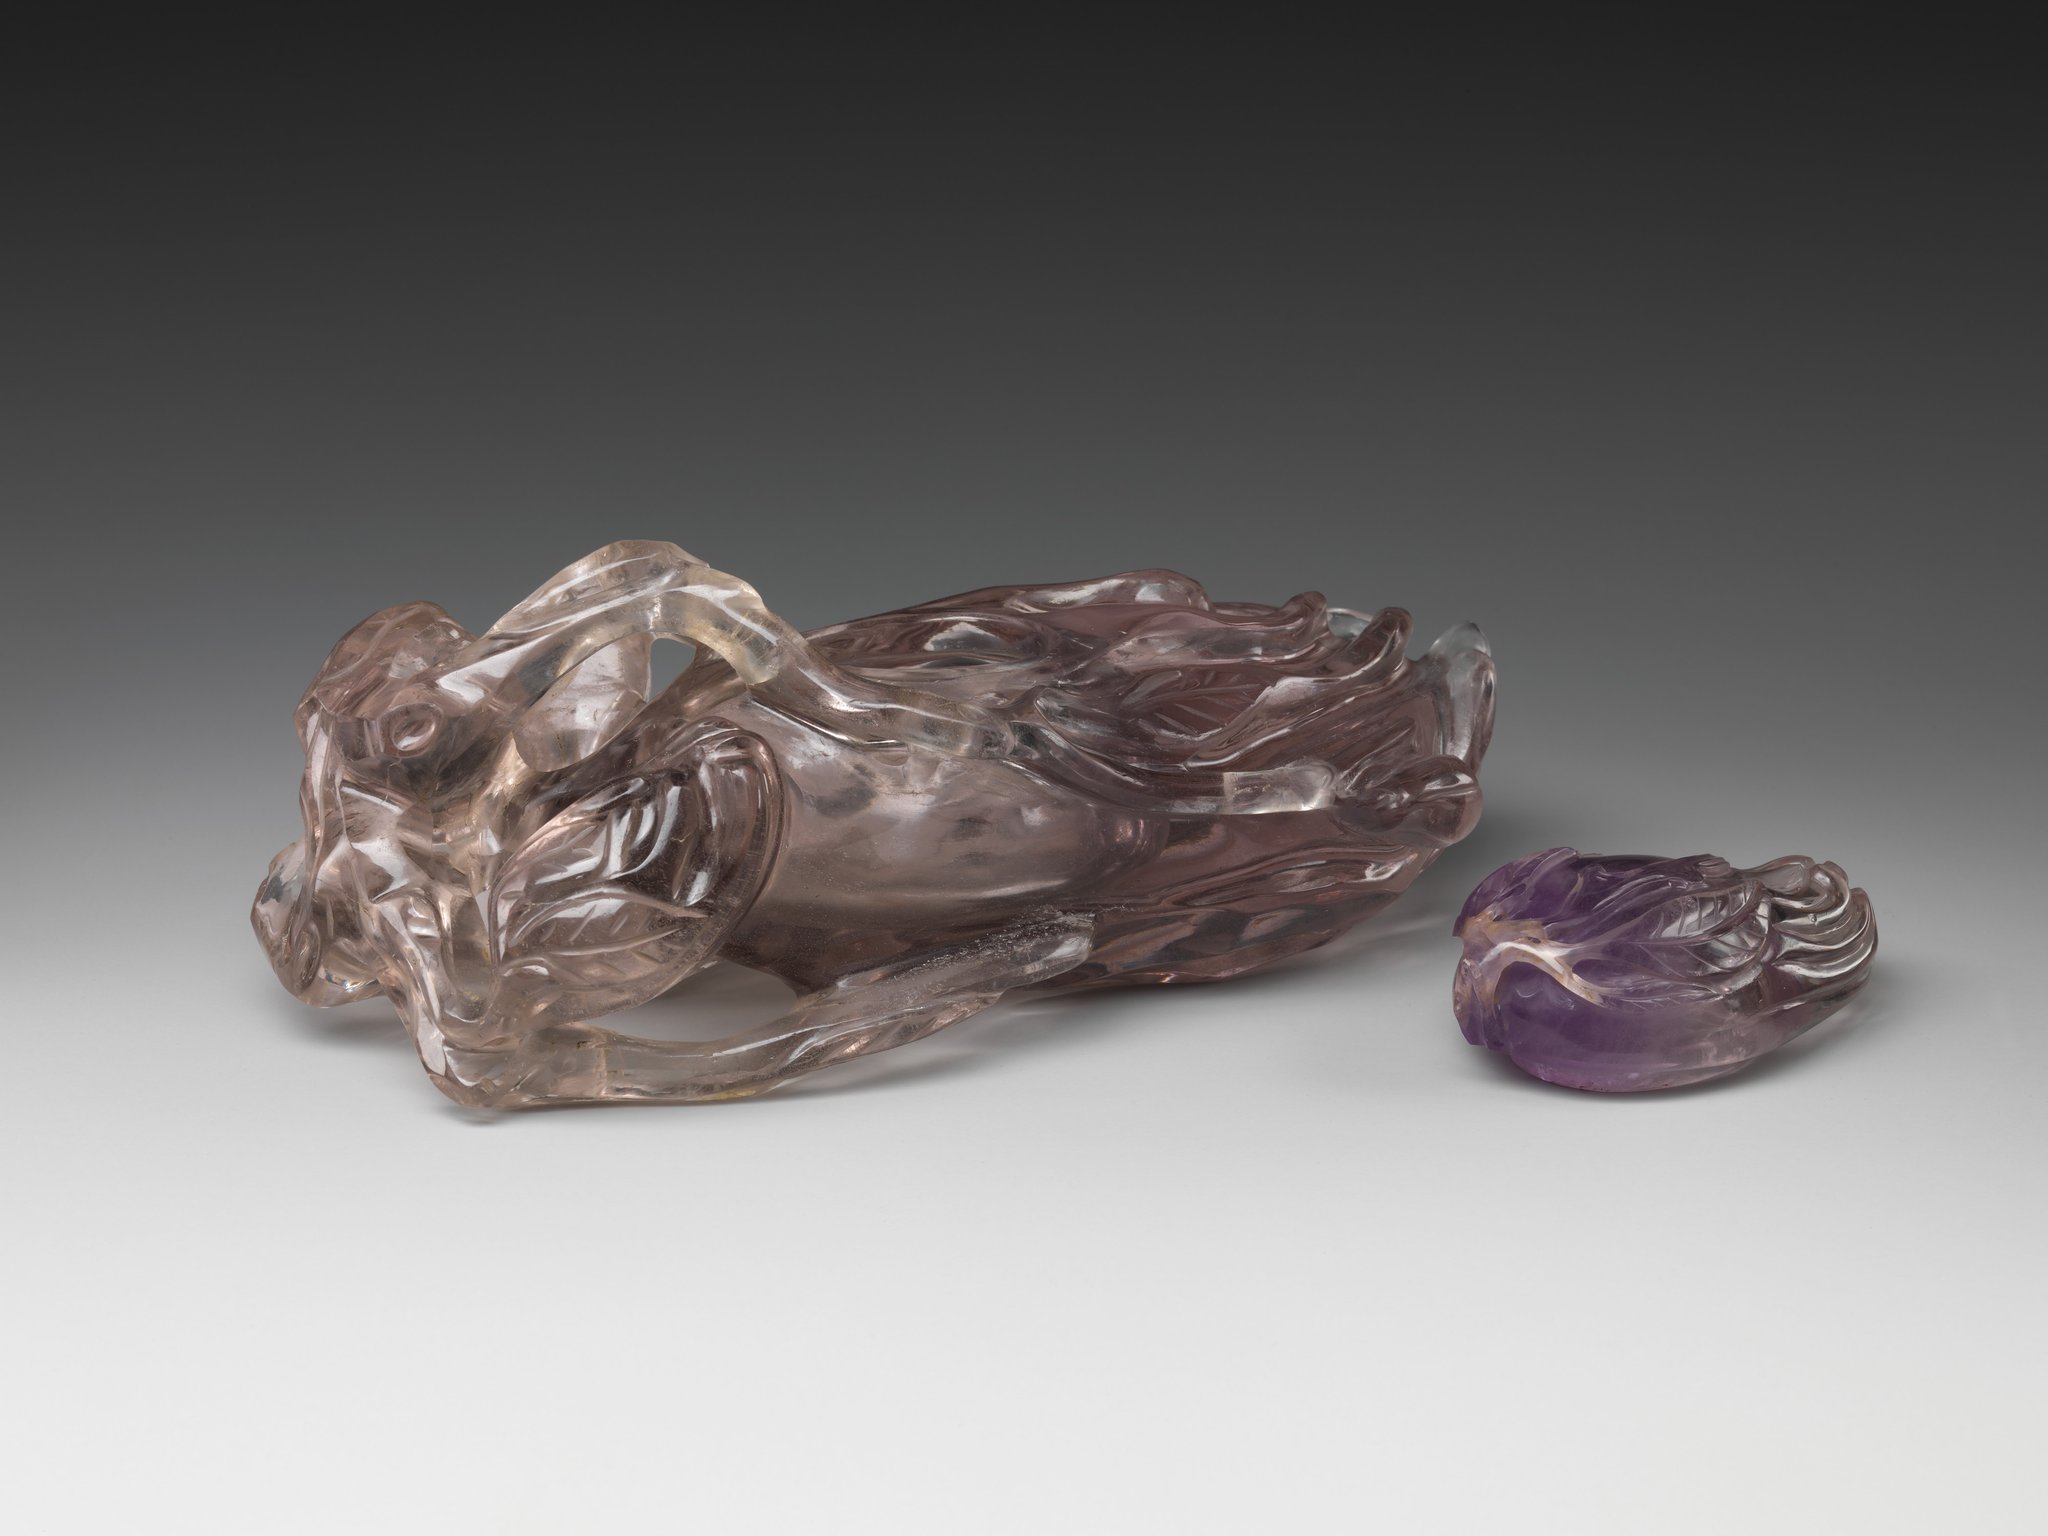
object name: container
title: Container in the shape of a Buddha’s hand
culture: chinese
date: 1701-1800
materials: gemstone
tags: hands